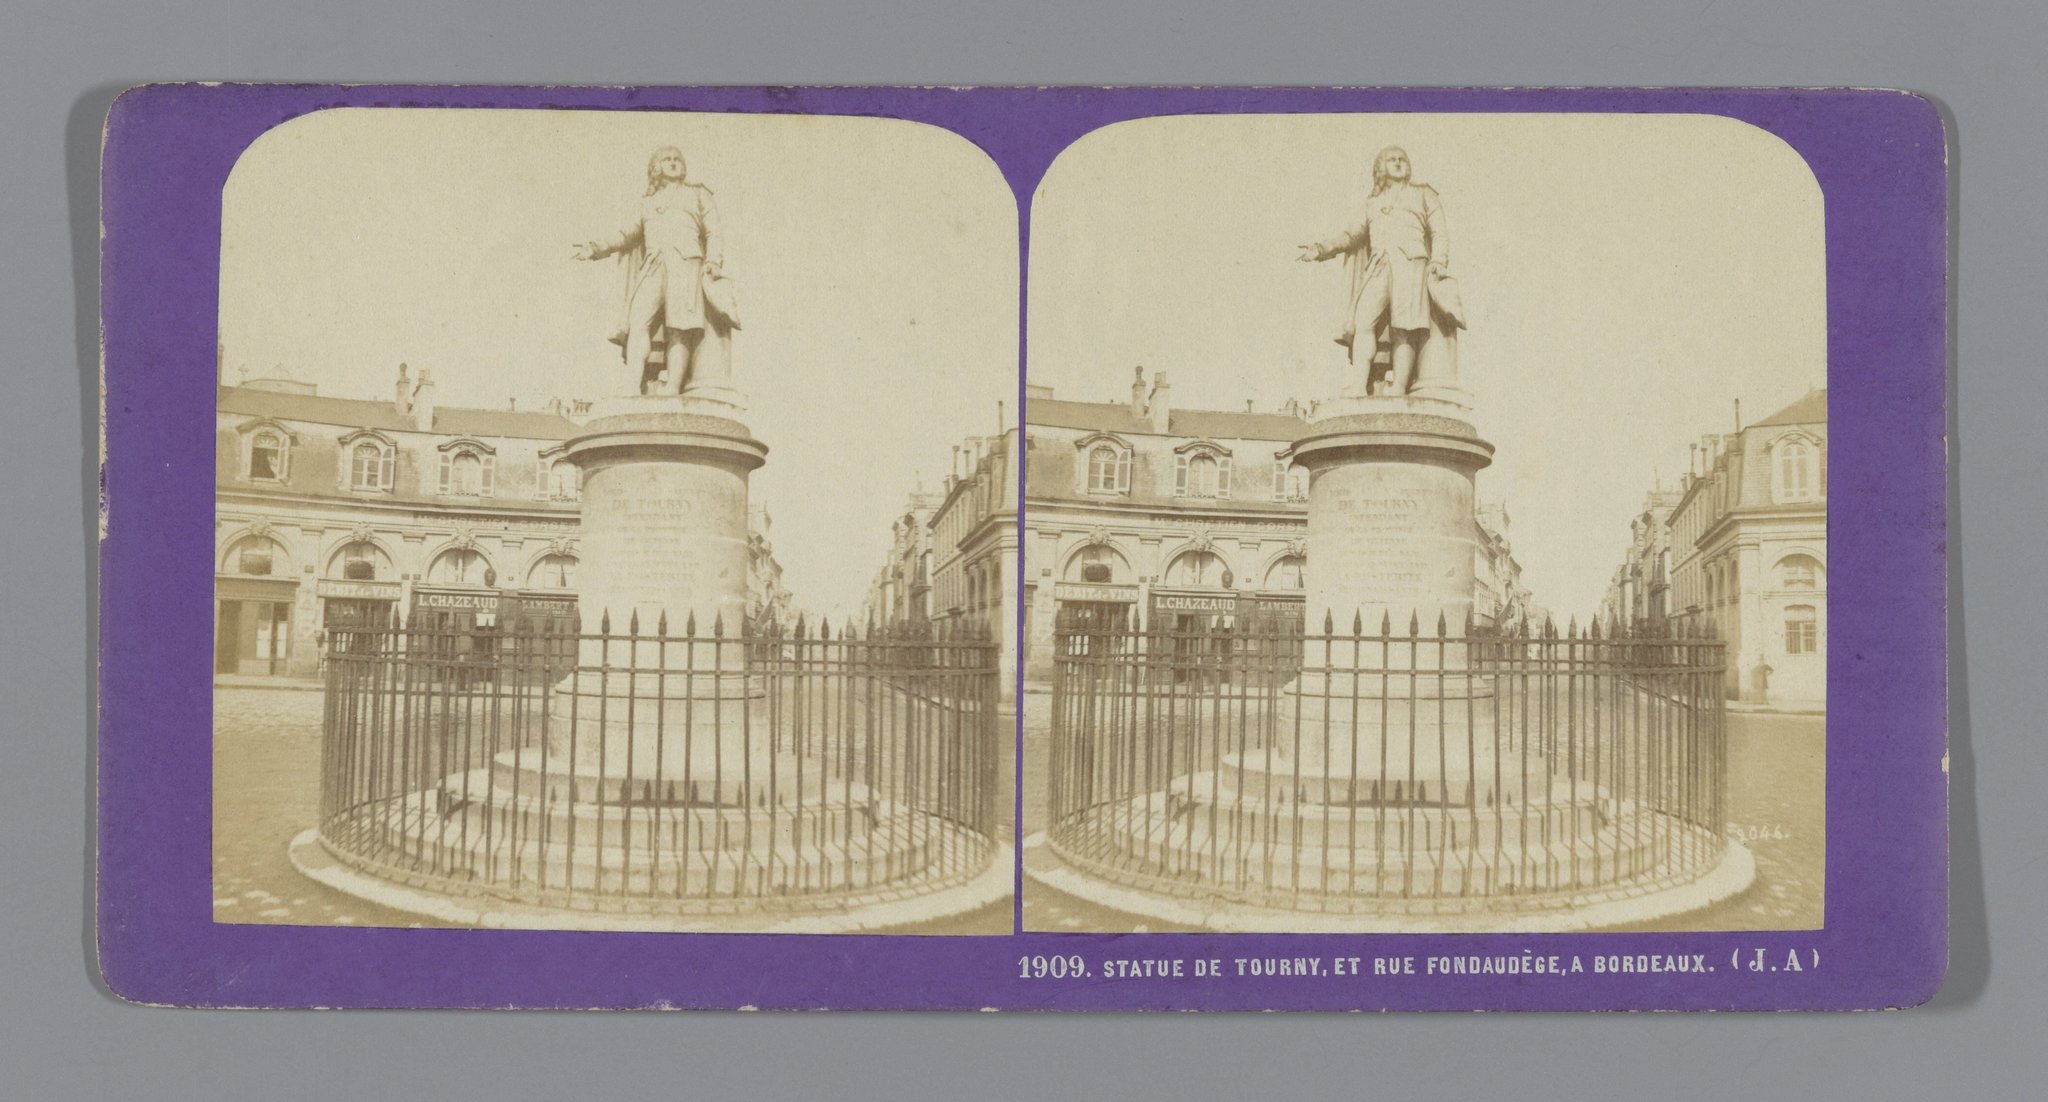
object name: stereograph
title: Statue de Tourny, et Rue Fondaudège, a Bordeaux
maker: jean andrieu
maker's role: fotograaf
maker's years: 1816-1872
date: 1862-1876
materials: cardboard, photographic support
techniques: albumen print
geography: bordeaux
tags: sculpture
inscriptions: number: ‘1909.’